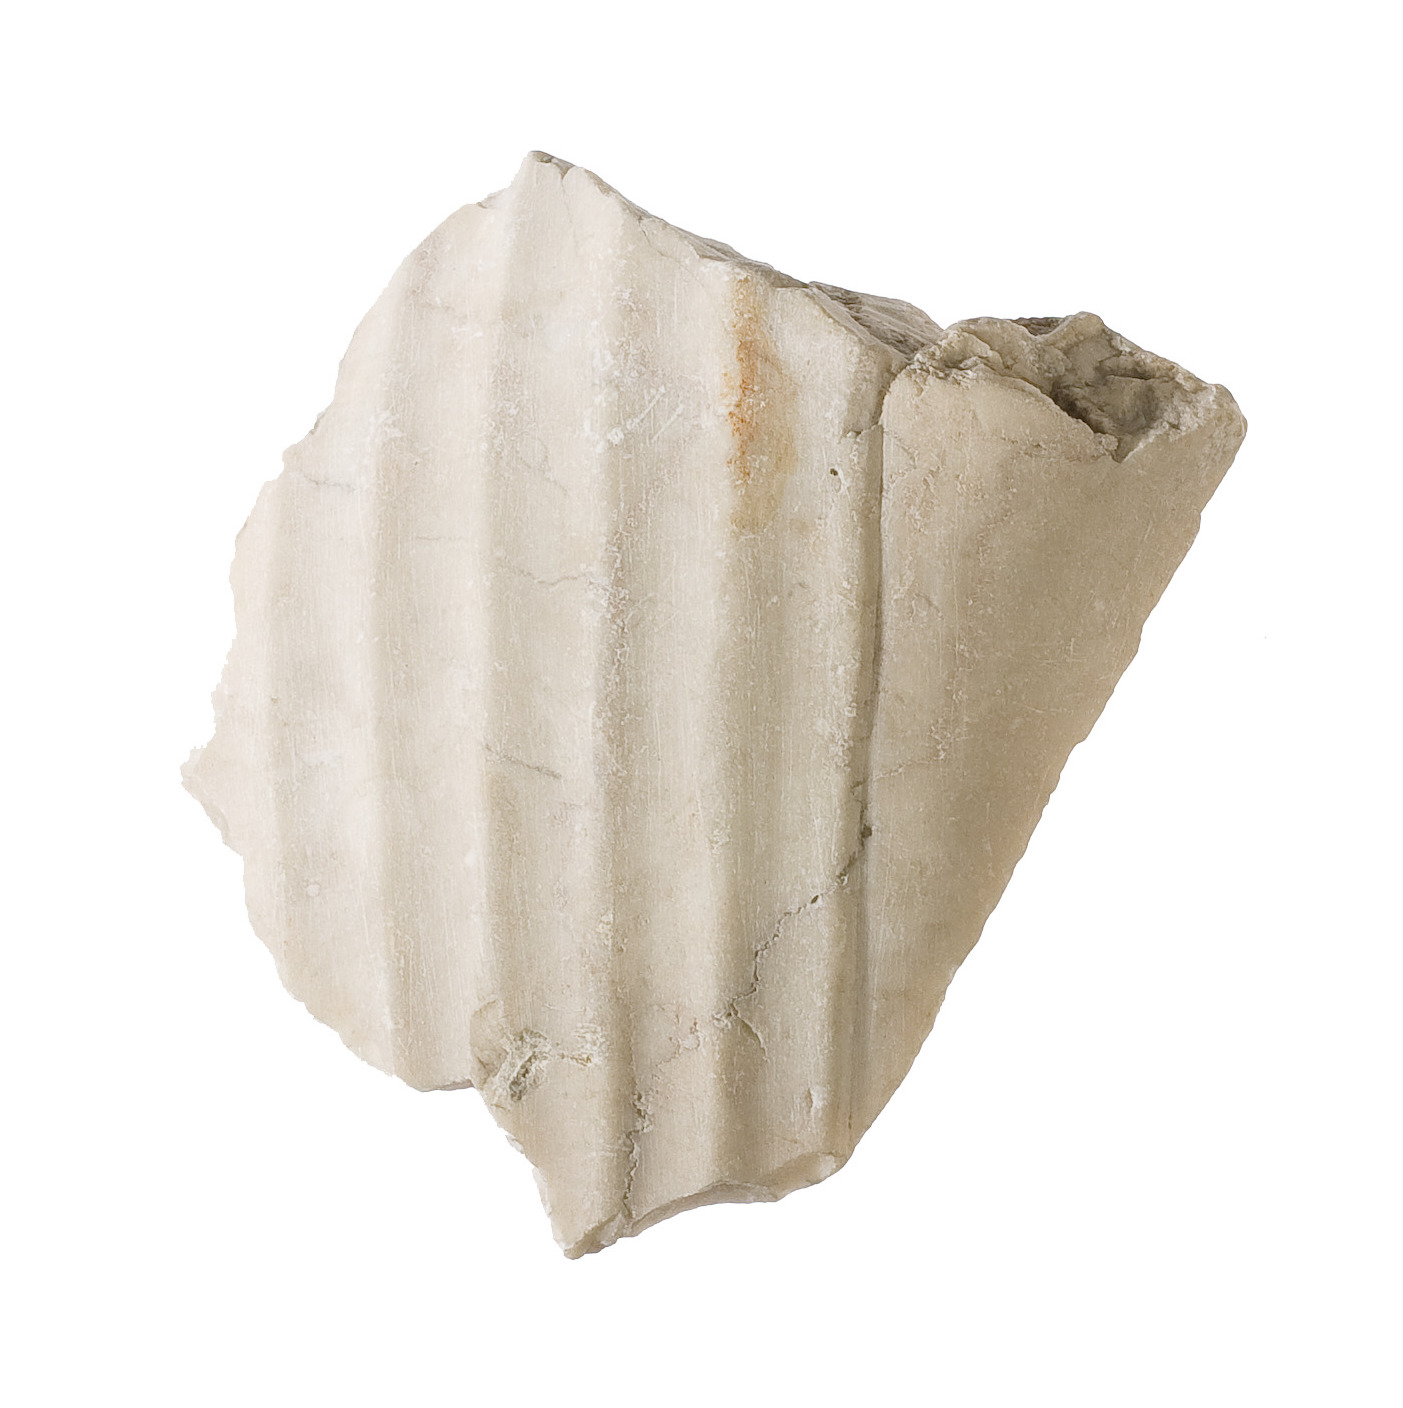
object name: garment fragment, kilt, knee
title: Garment fragment, royal kilt at the knee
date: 1353-1336 BCE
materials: limestone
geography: egypt